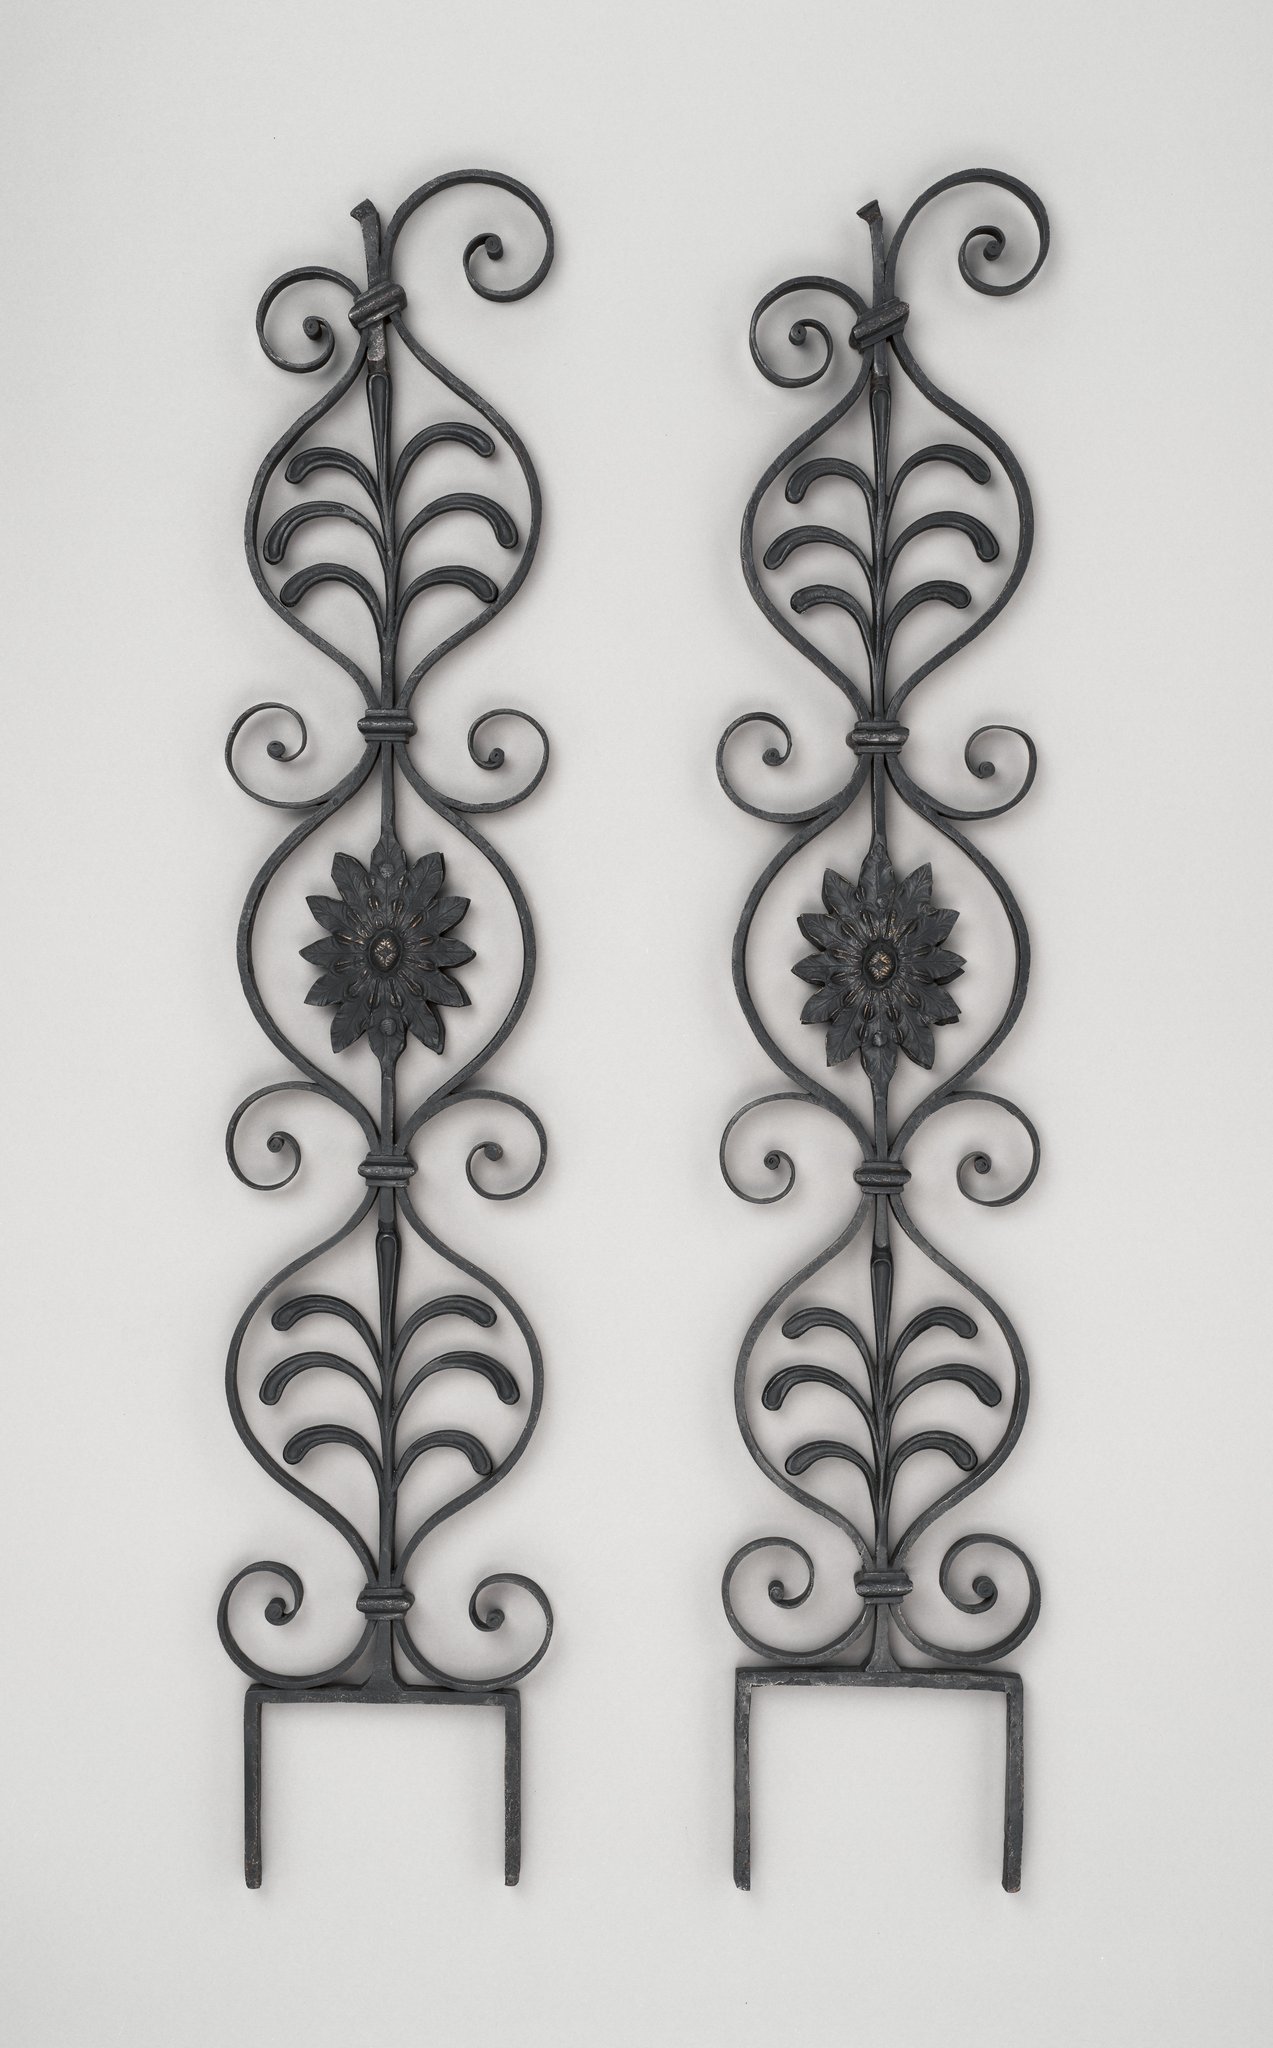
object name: baluster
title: Iron baluster (one of a pair)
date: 1770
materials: brass, iron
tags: flowers